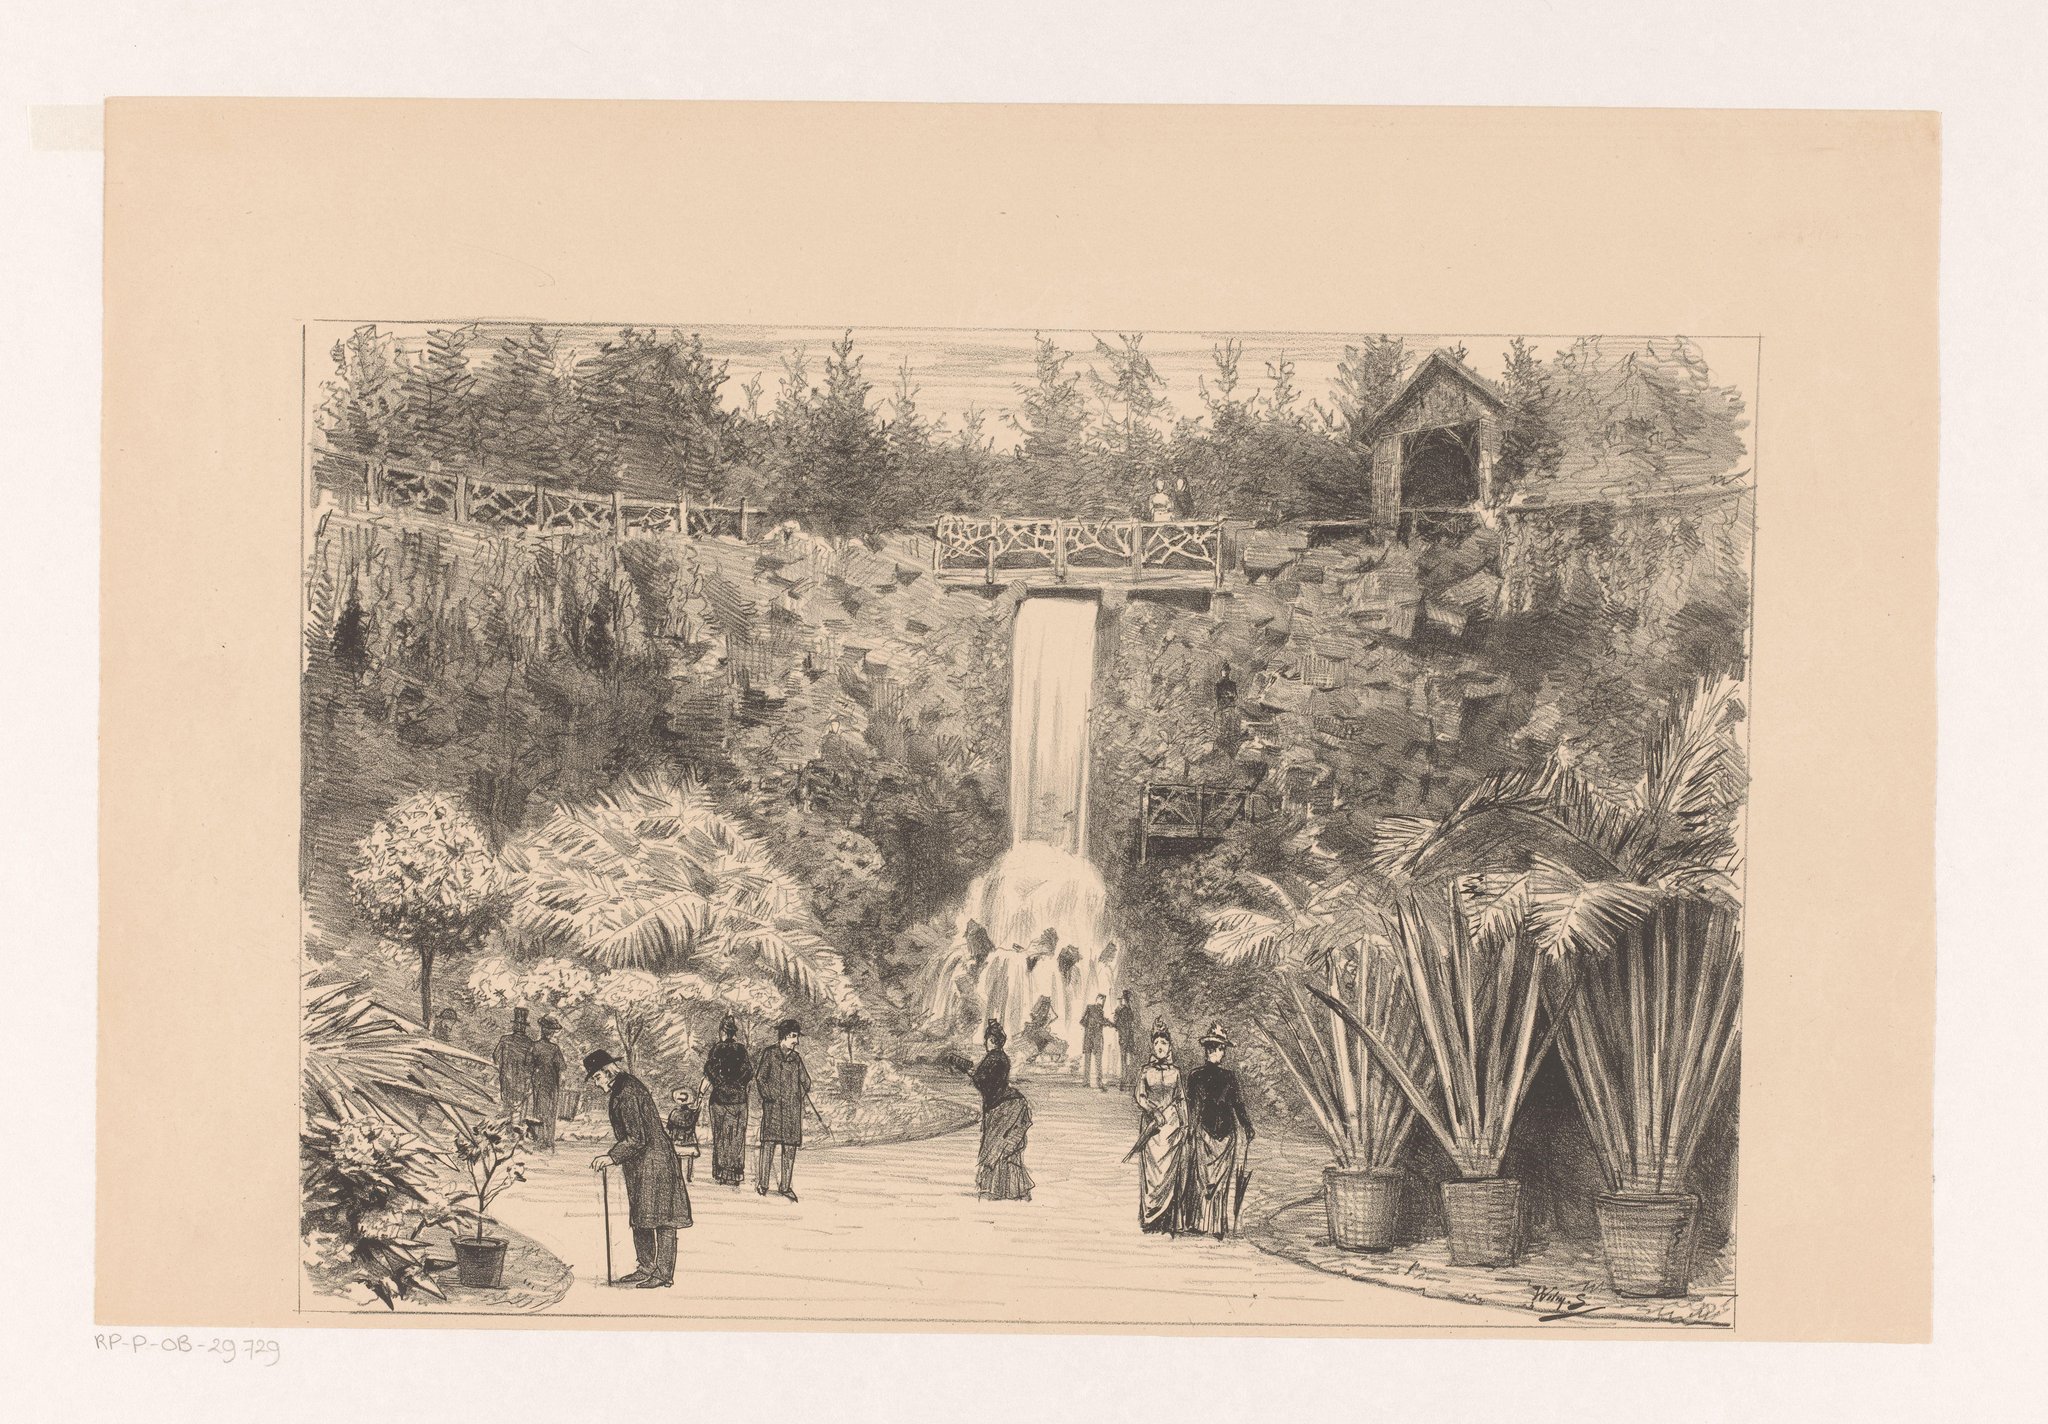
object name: print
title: De Waterval naar de plannen van den Heer Leonard A. Springer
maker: willem steelink (ii)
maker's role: draughtsman, print maker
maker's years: 1856-1928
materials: paper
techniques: lithograph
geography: netherlands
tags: park, waterfall, deventer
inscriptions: collector's mark: Lugt 2228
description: Figuren wandelen bij een waterval in een park, mogelijk het in 1887 geopende Rijsterborgherpark.